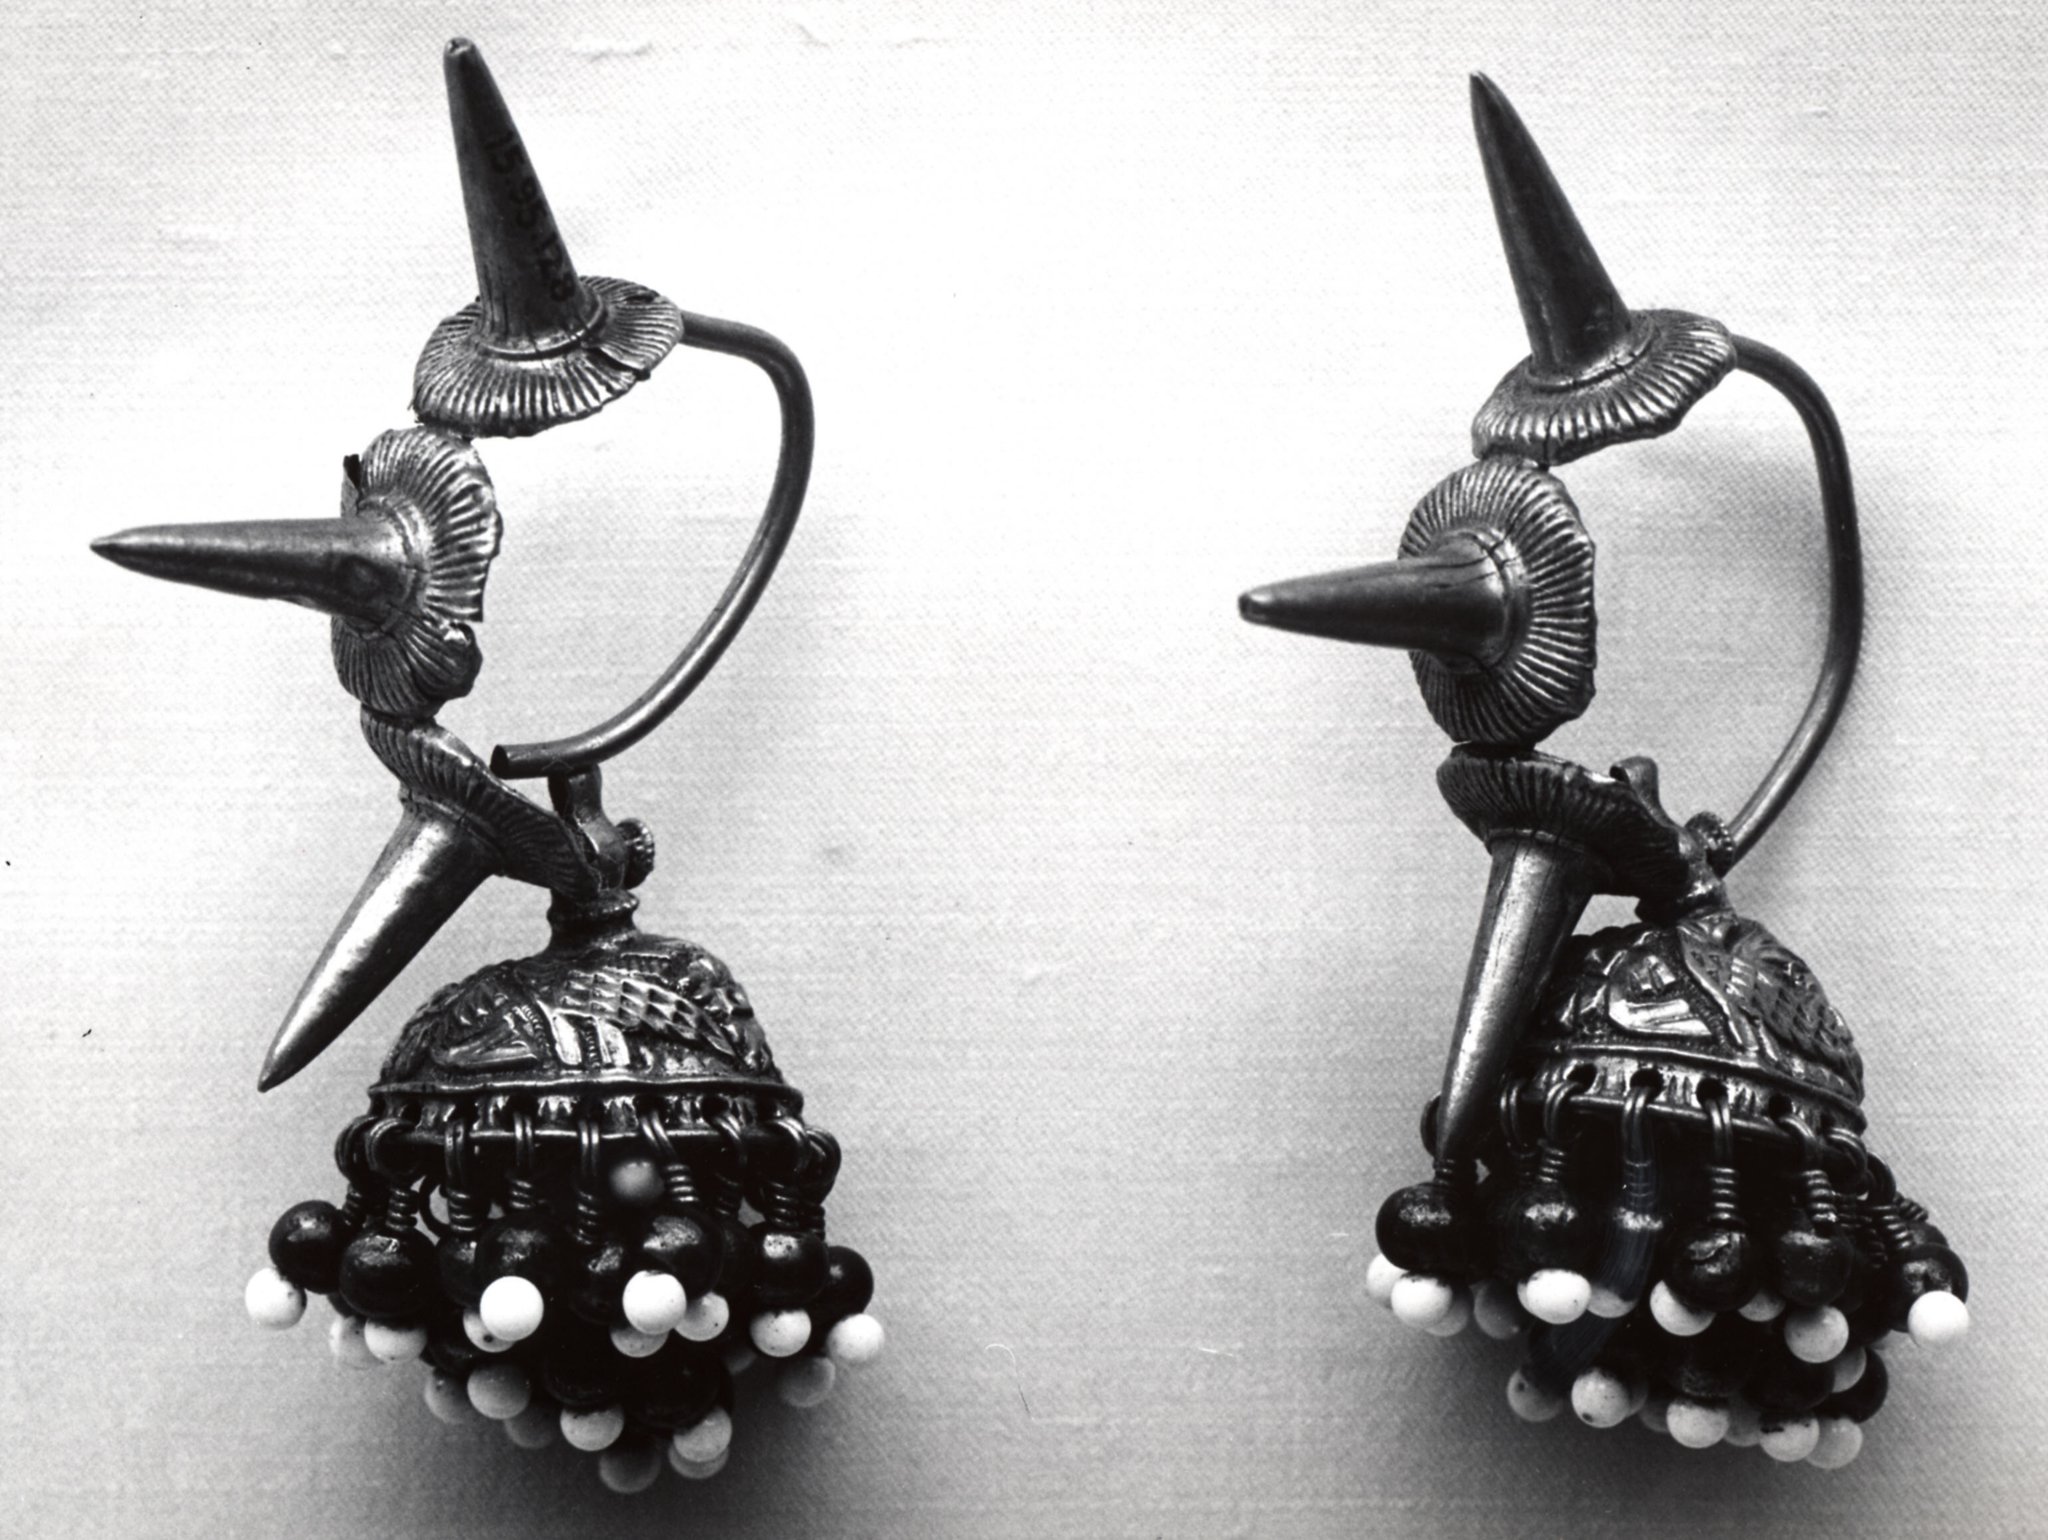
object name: nose ring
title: Nose Ring, One of a Pair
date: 1701-1900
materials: gold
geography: india